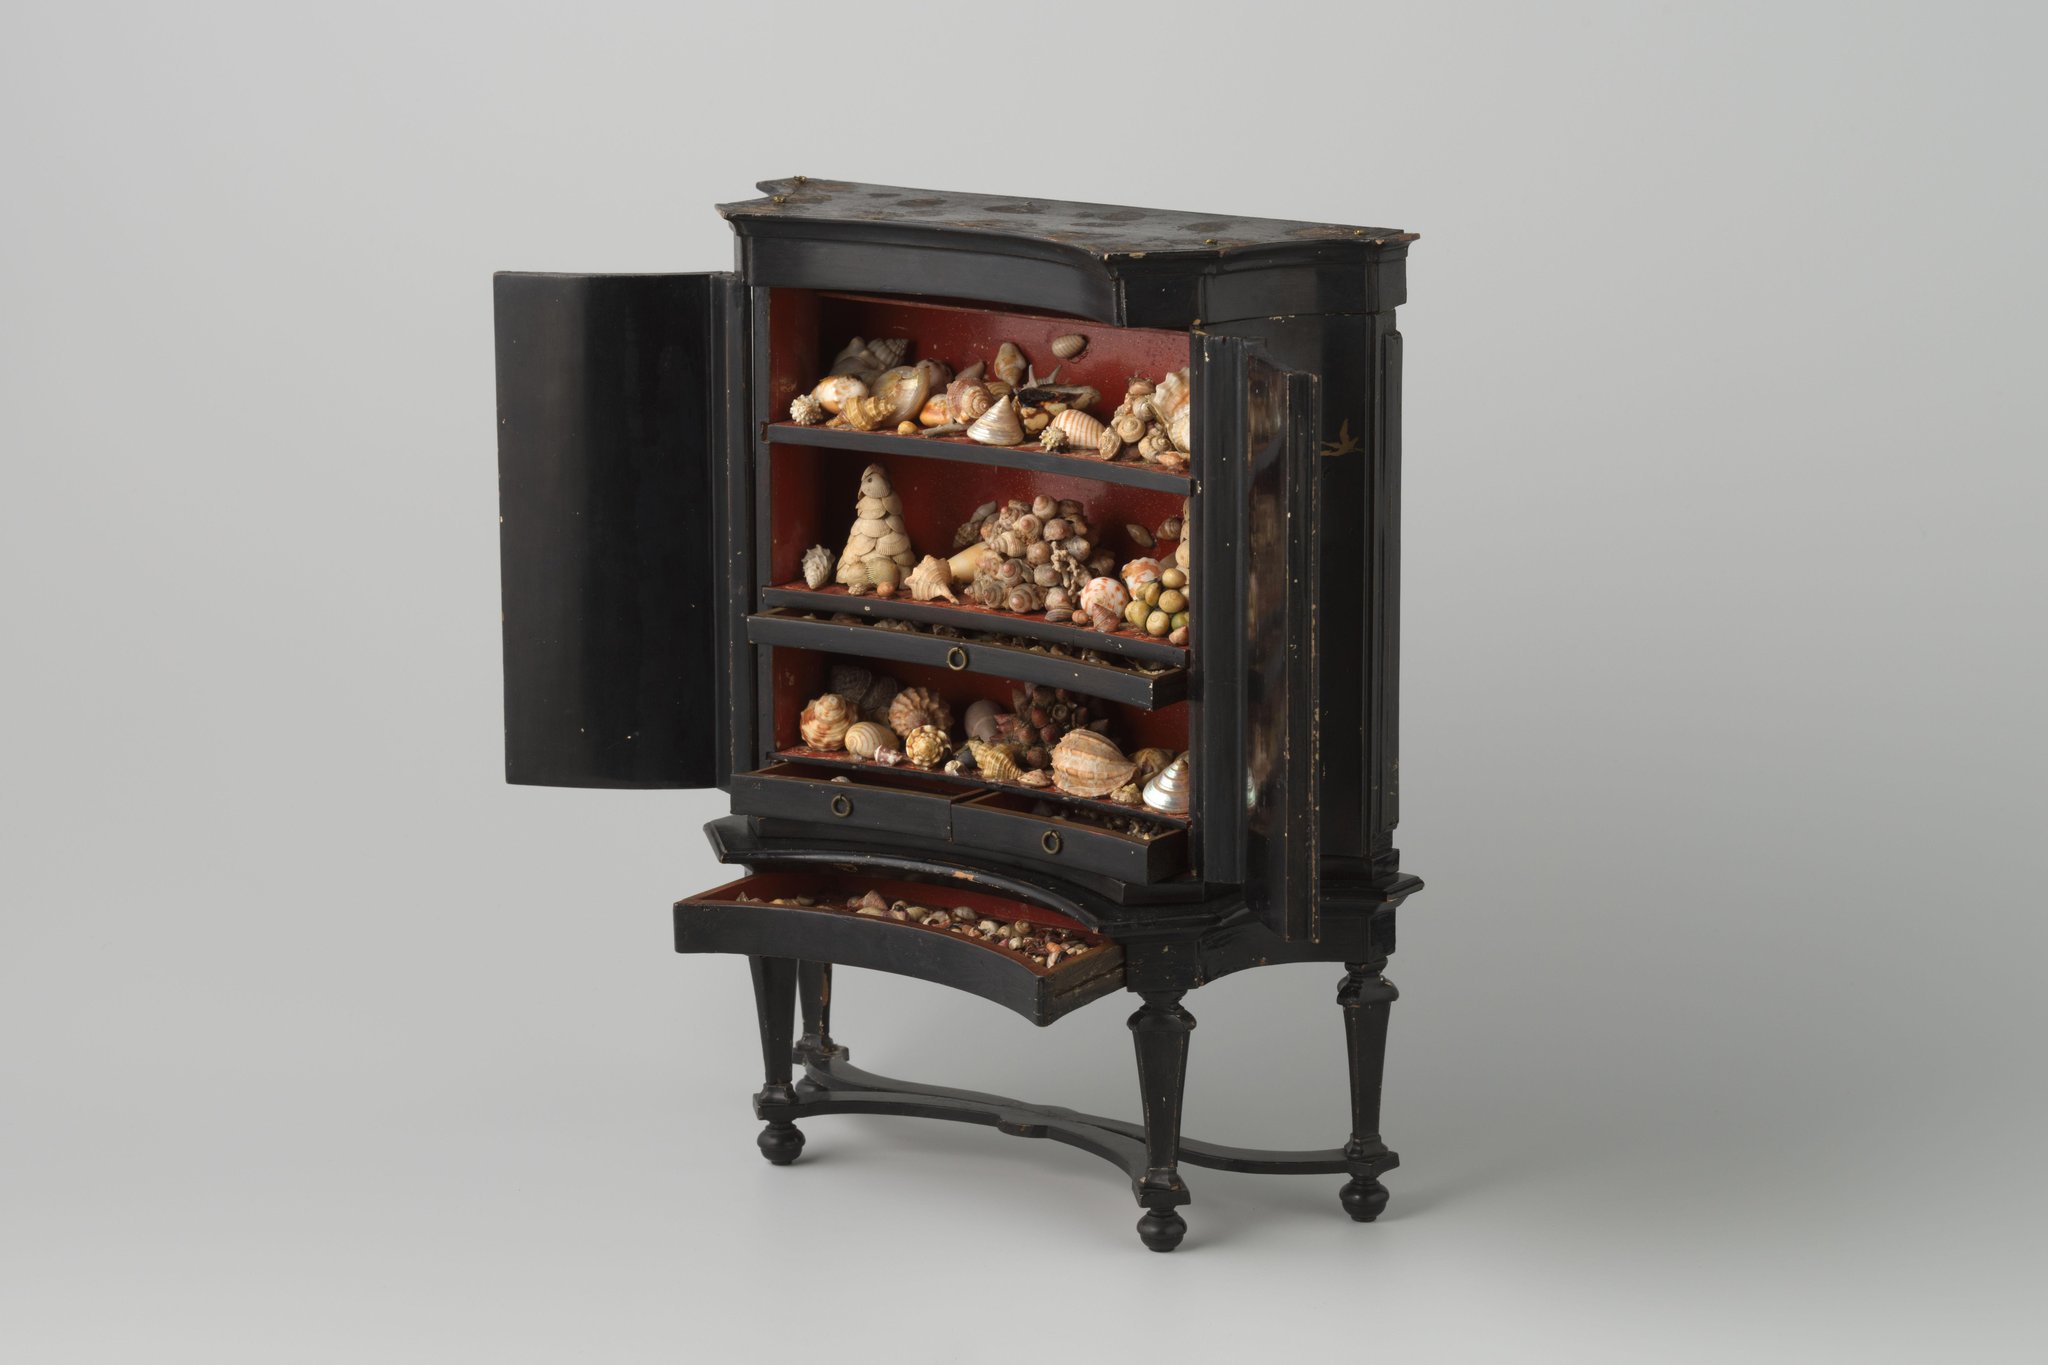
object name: miniature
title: Kunstkabinet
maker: Anonymous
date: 1690-1710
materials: wood, shell, wax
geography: amsterdam